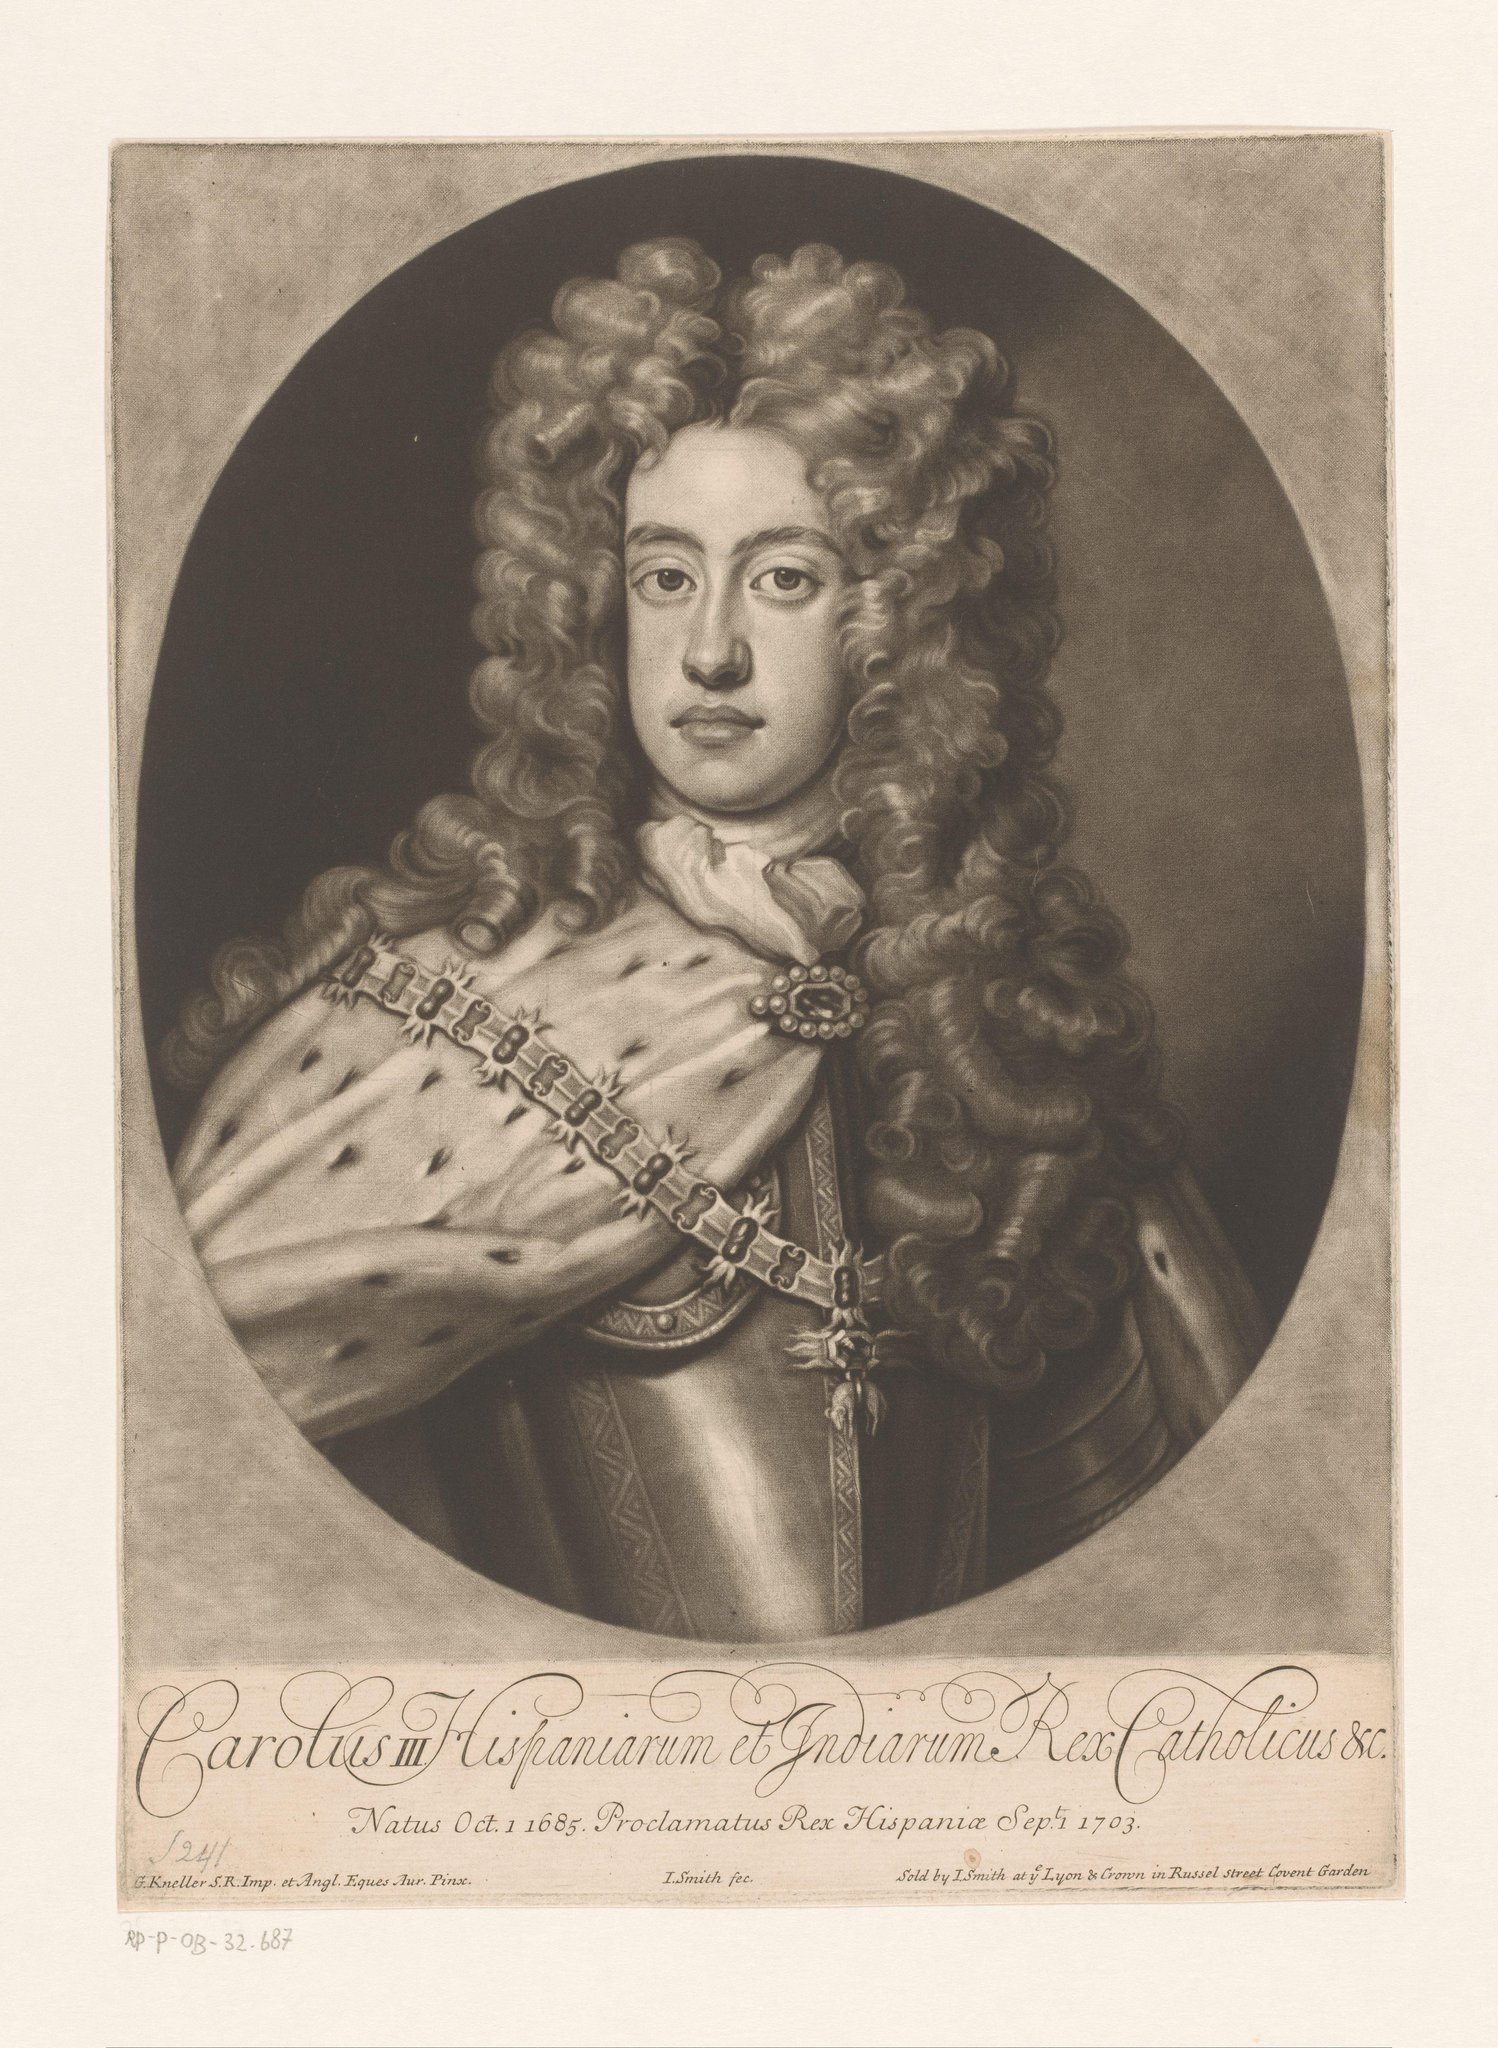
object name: print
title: Portret van keizer Karel VI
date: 1703-1742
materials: paper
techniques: mezzotint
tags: vienna, charles vi (holy roman emperor), historical persons, king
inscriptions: collector's mark: Lugt 240